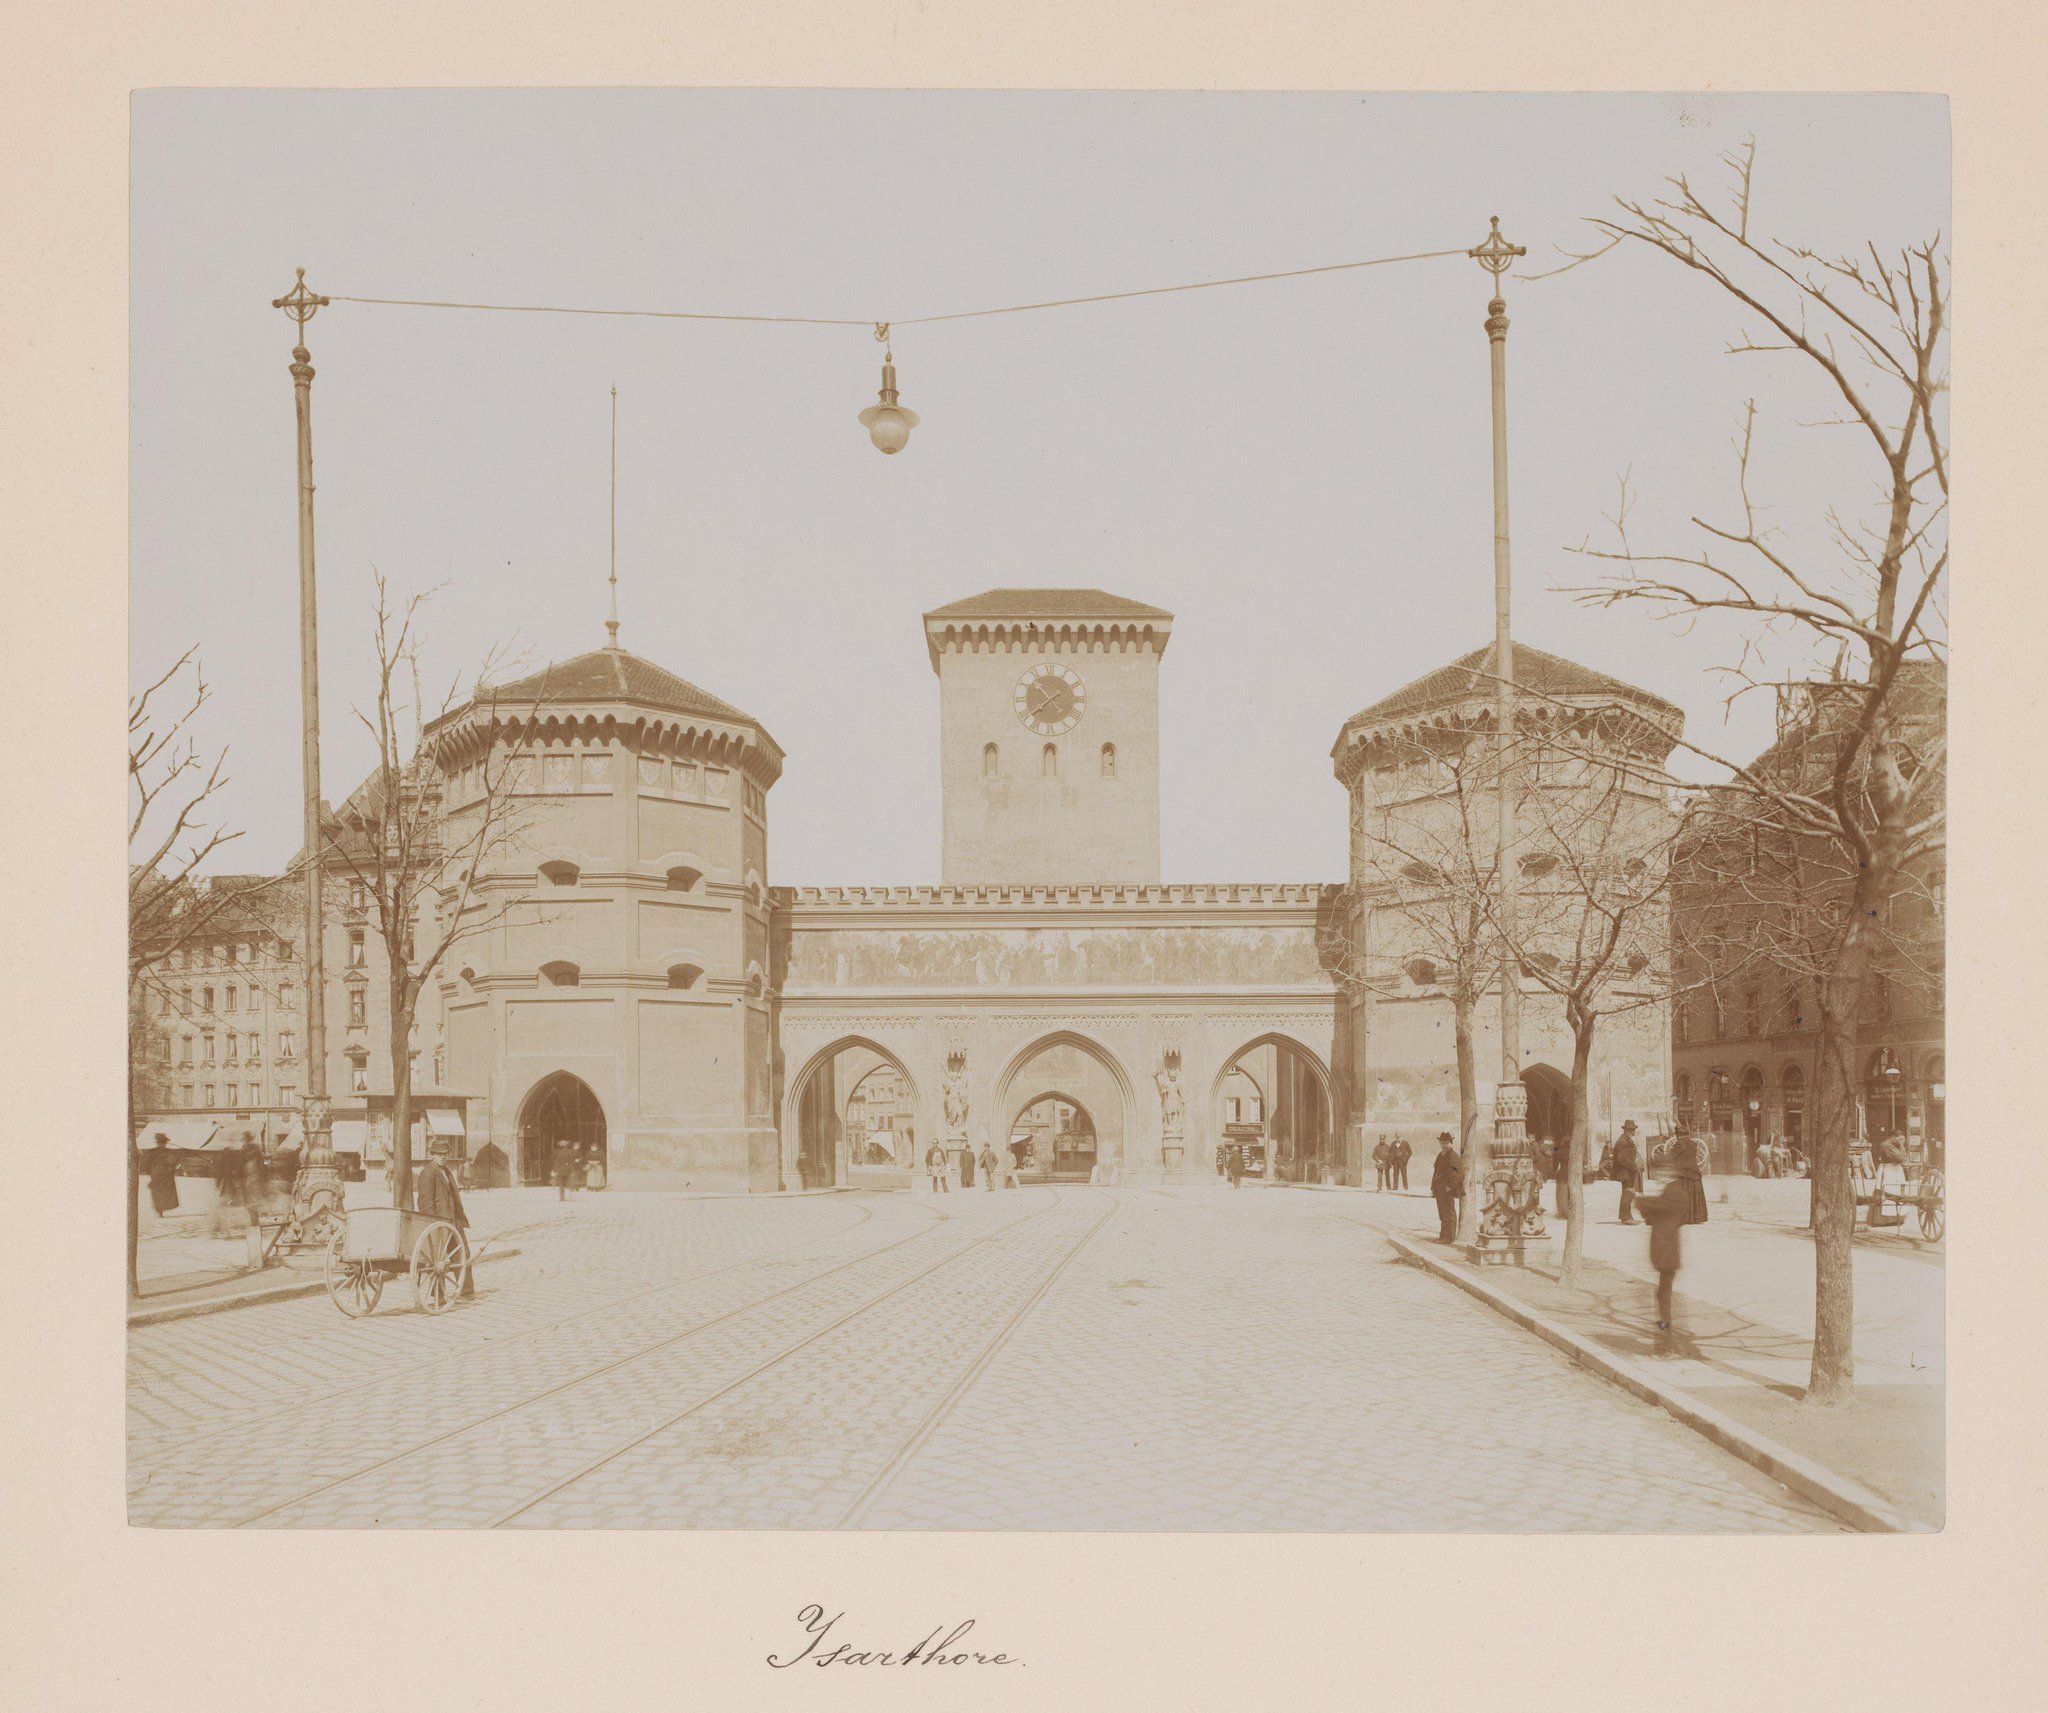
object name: photograph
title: Isarthor, München, Duitsland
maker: Anonymous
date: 1880-1910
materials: cardboard, photographic support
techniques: collodion silver print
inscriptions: inscription: ‘Isarthore. [sic]’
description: Frontaal aanzicht op het Isarthor in München, Duitsland. Links een man met een handkar, rechts andere poserende voorbijgangers.